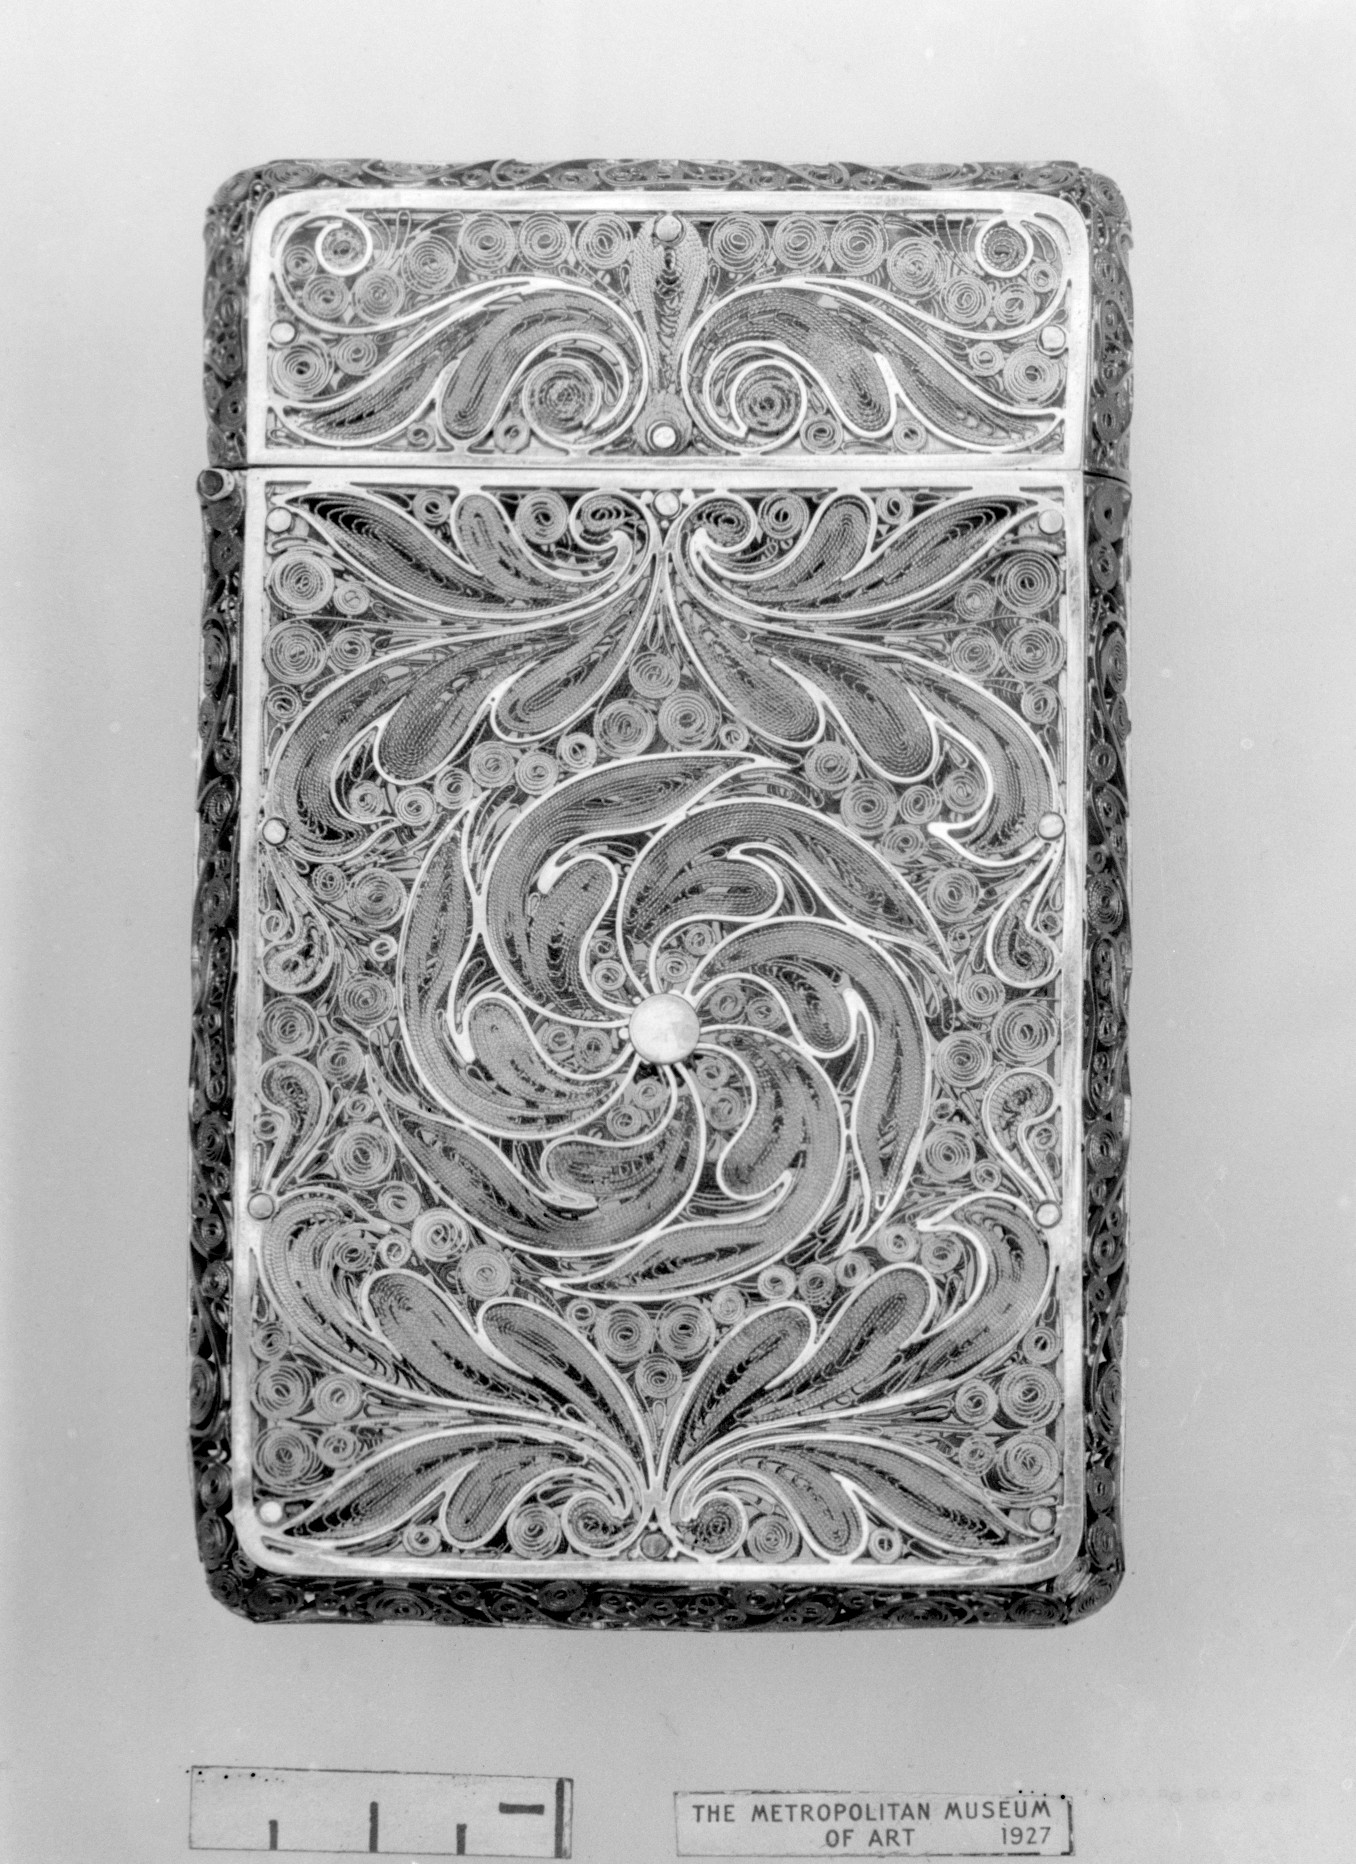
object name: card case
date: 1801-1900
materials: gold